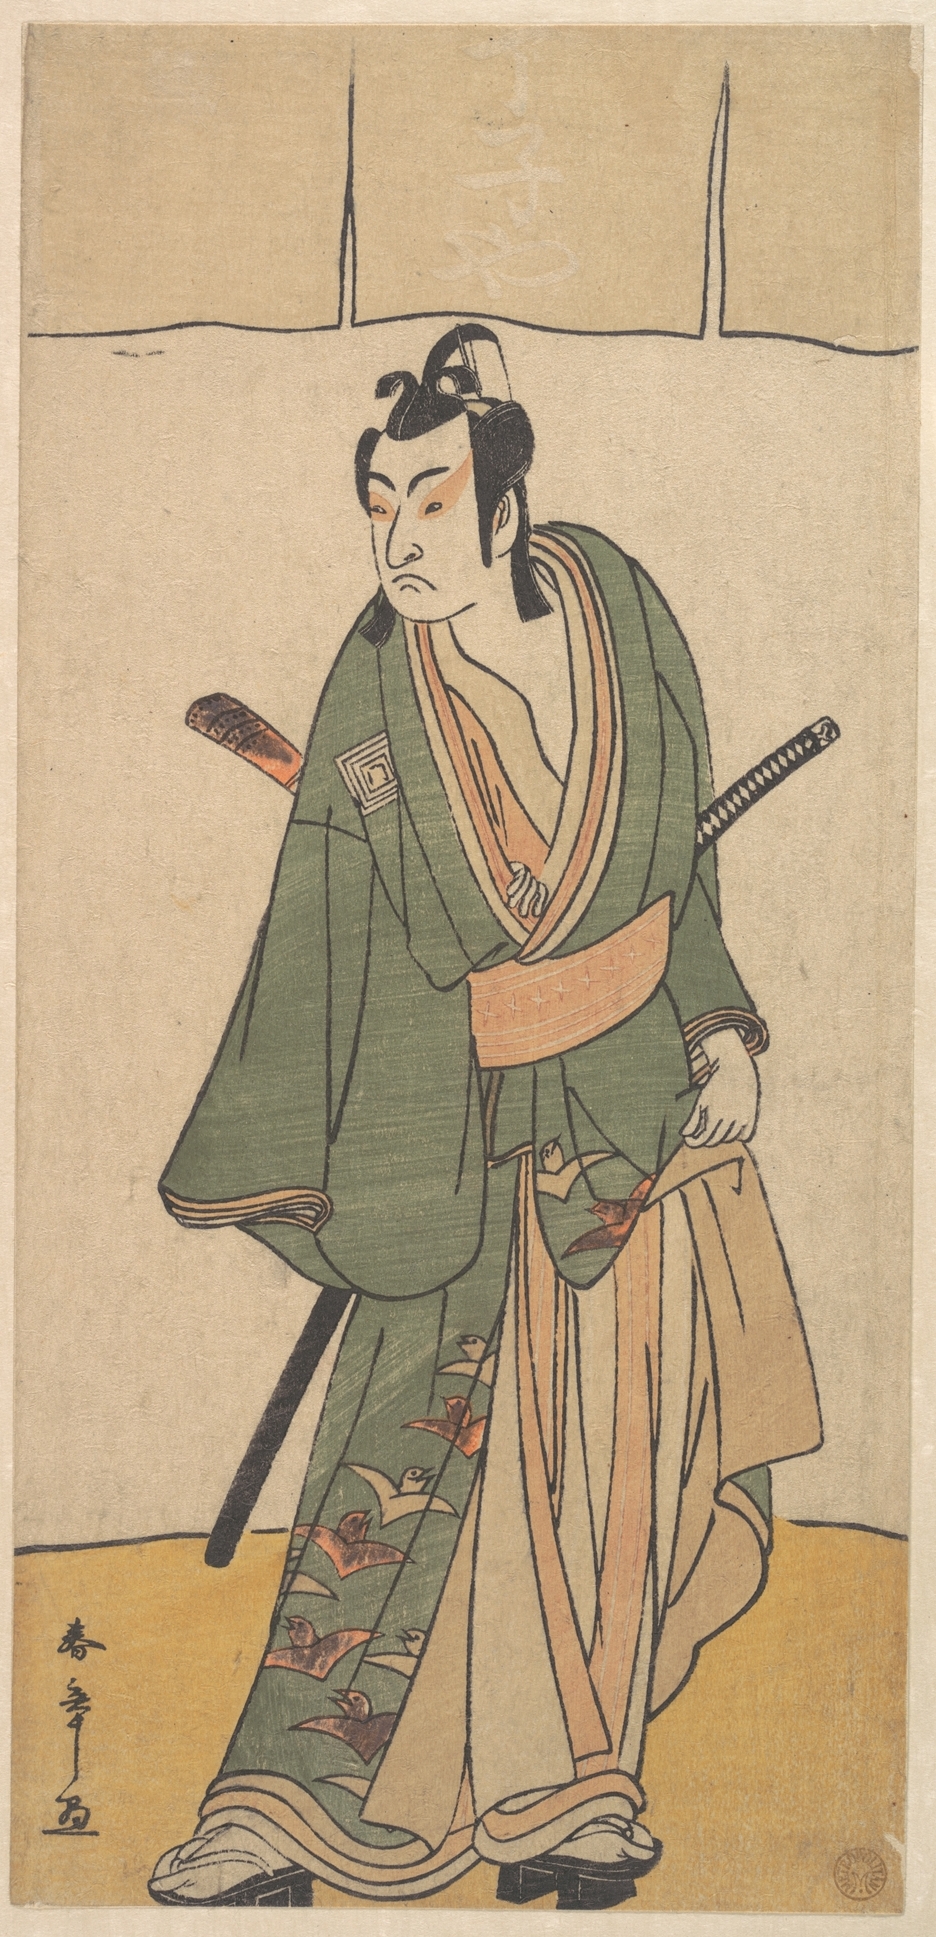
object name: woodblock print nishiki e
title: The Second Ichikawa Monnosuke in the role of Soga no Juro Sukenari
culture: japanese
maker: katsukawa shunshō 勝川春章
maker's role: artist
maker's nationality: japanese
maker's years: 1726-1792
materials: ink, paper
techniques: nishiki e, woodblock print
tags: swords,men,actors